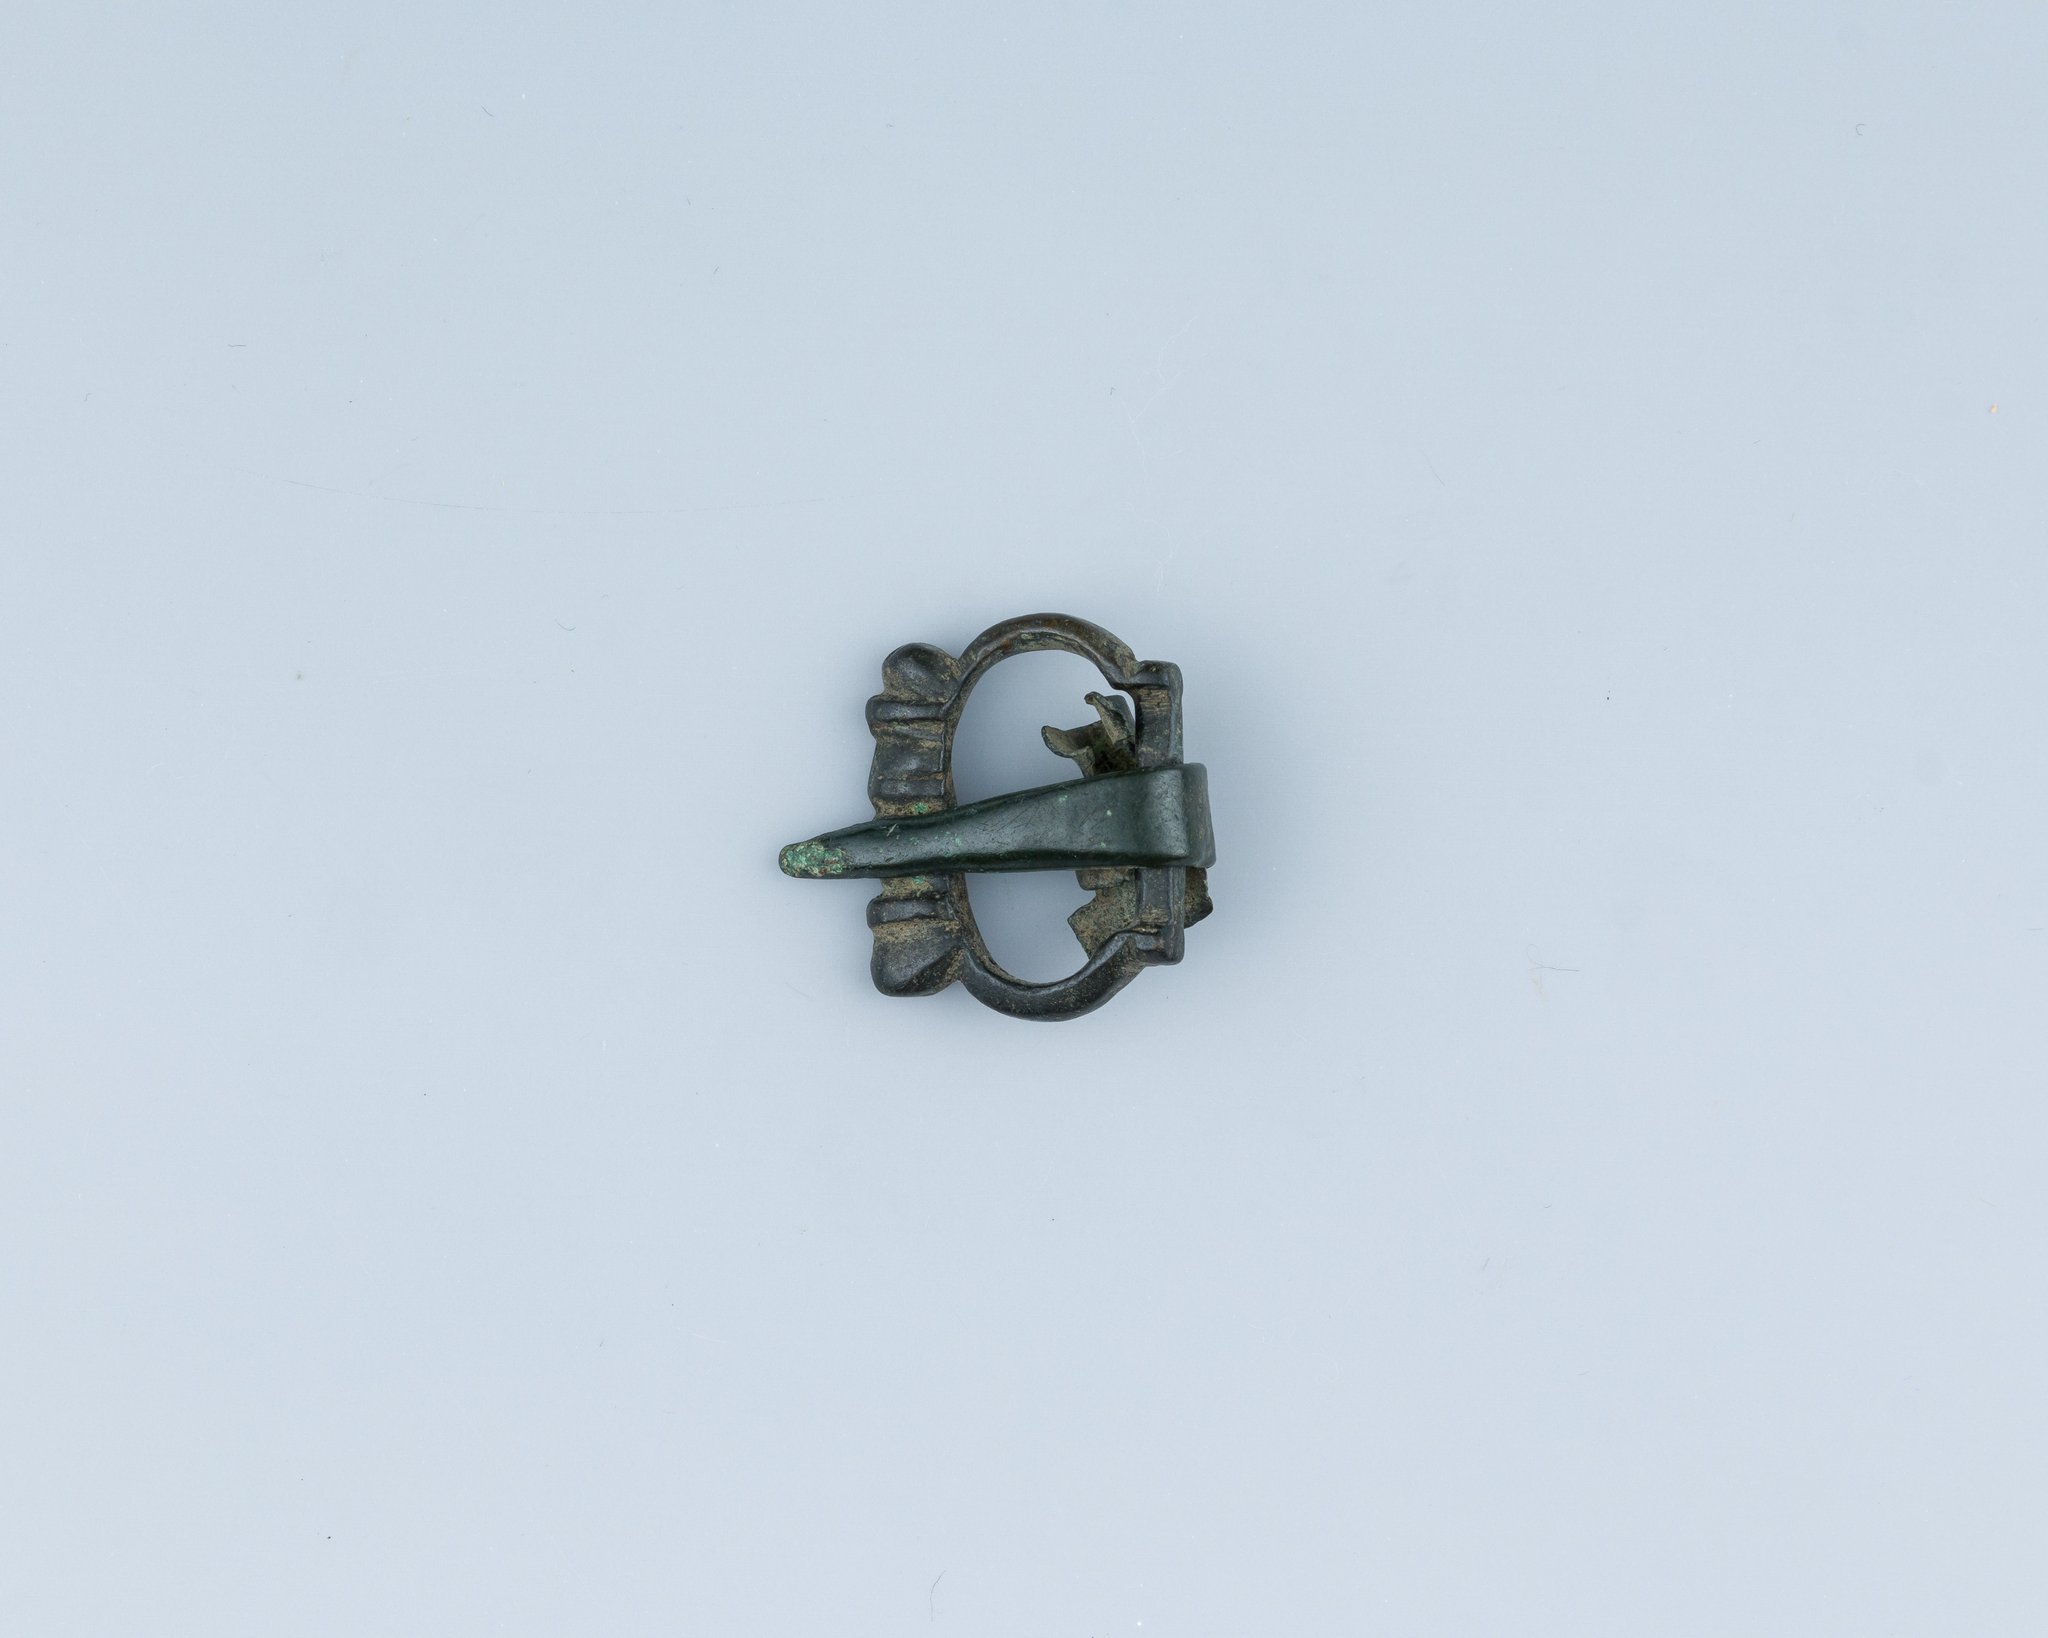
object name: buckle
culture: european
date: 1401-1600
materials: bronze